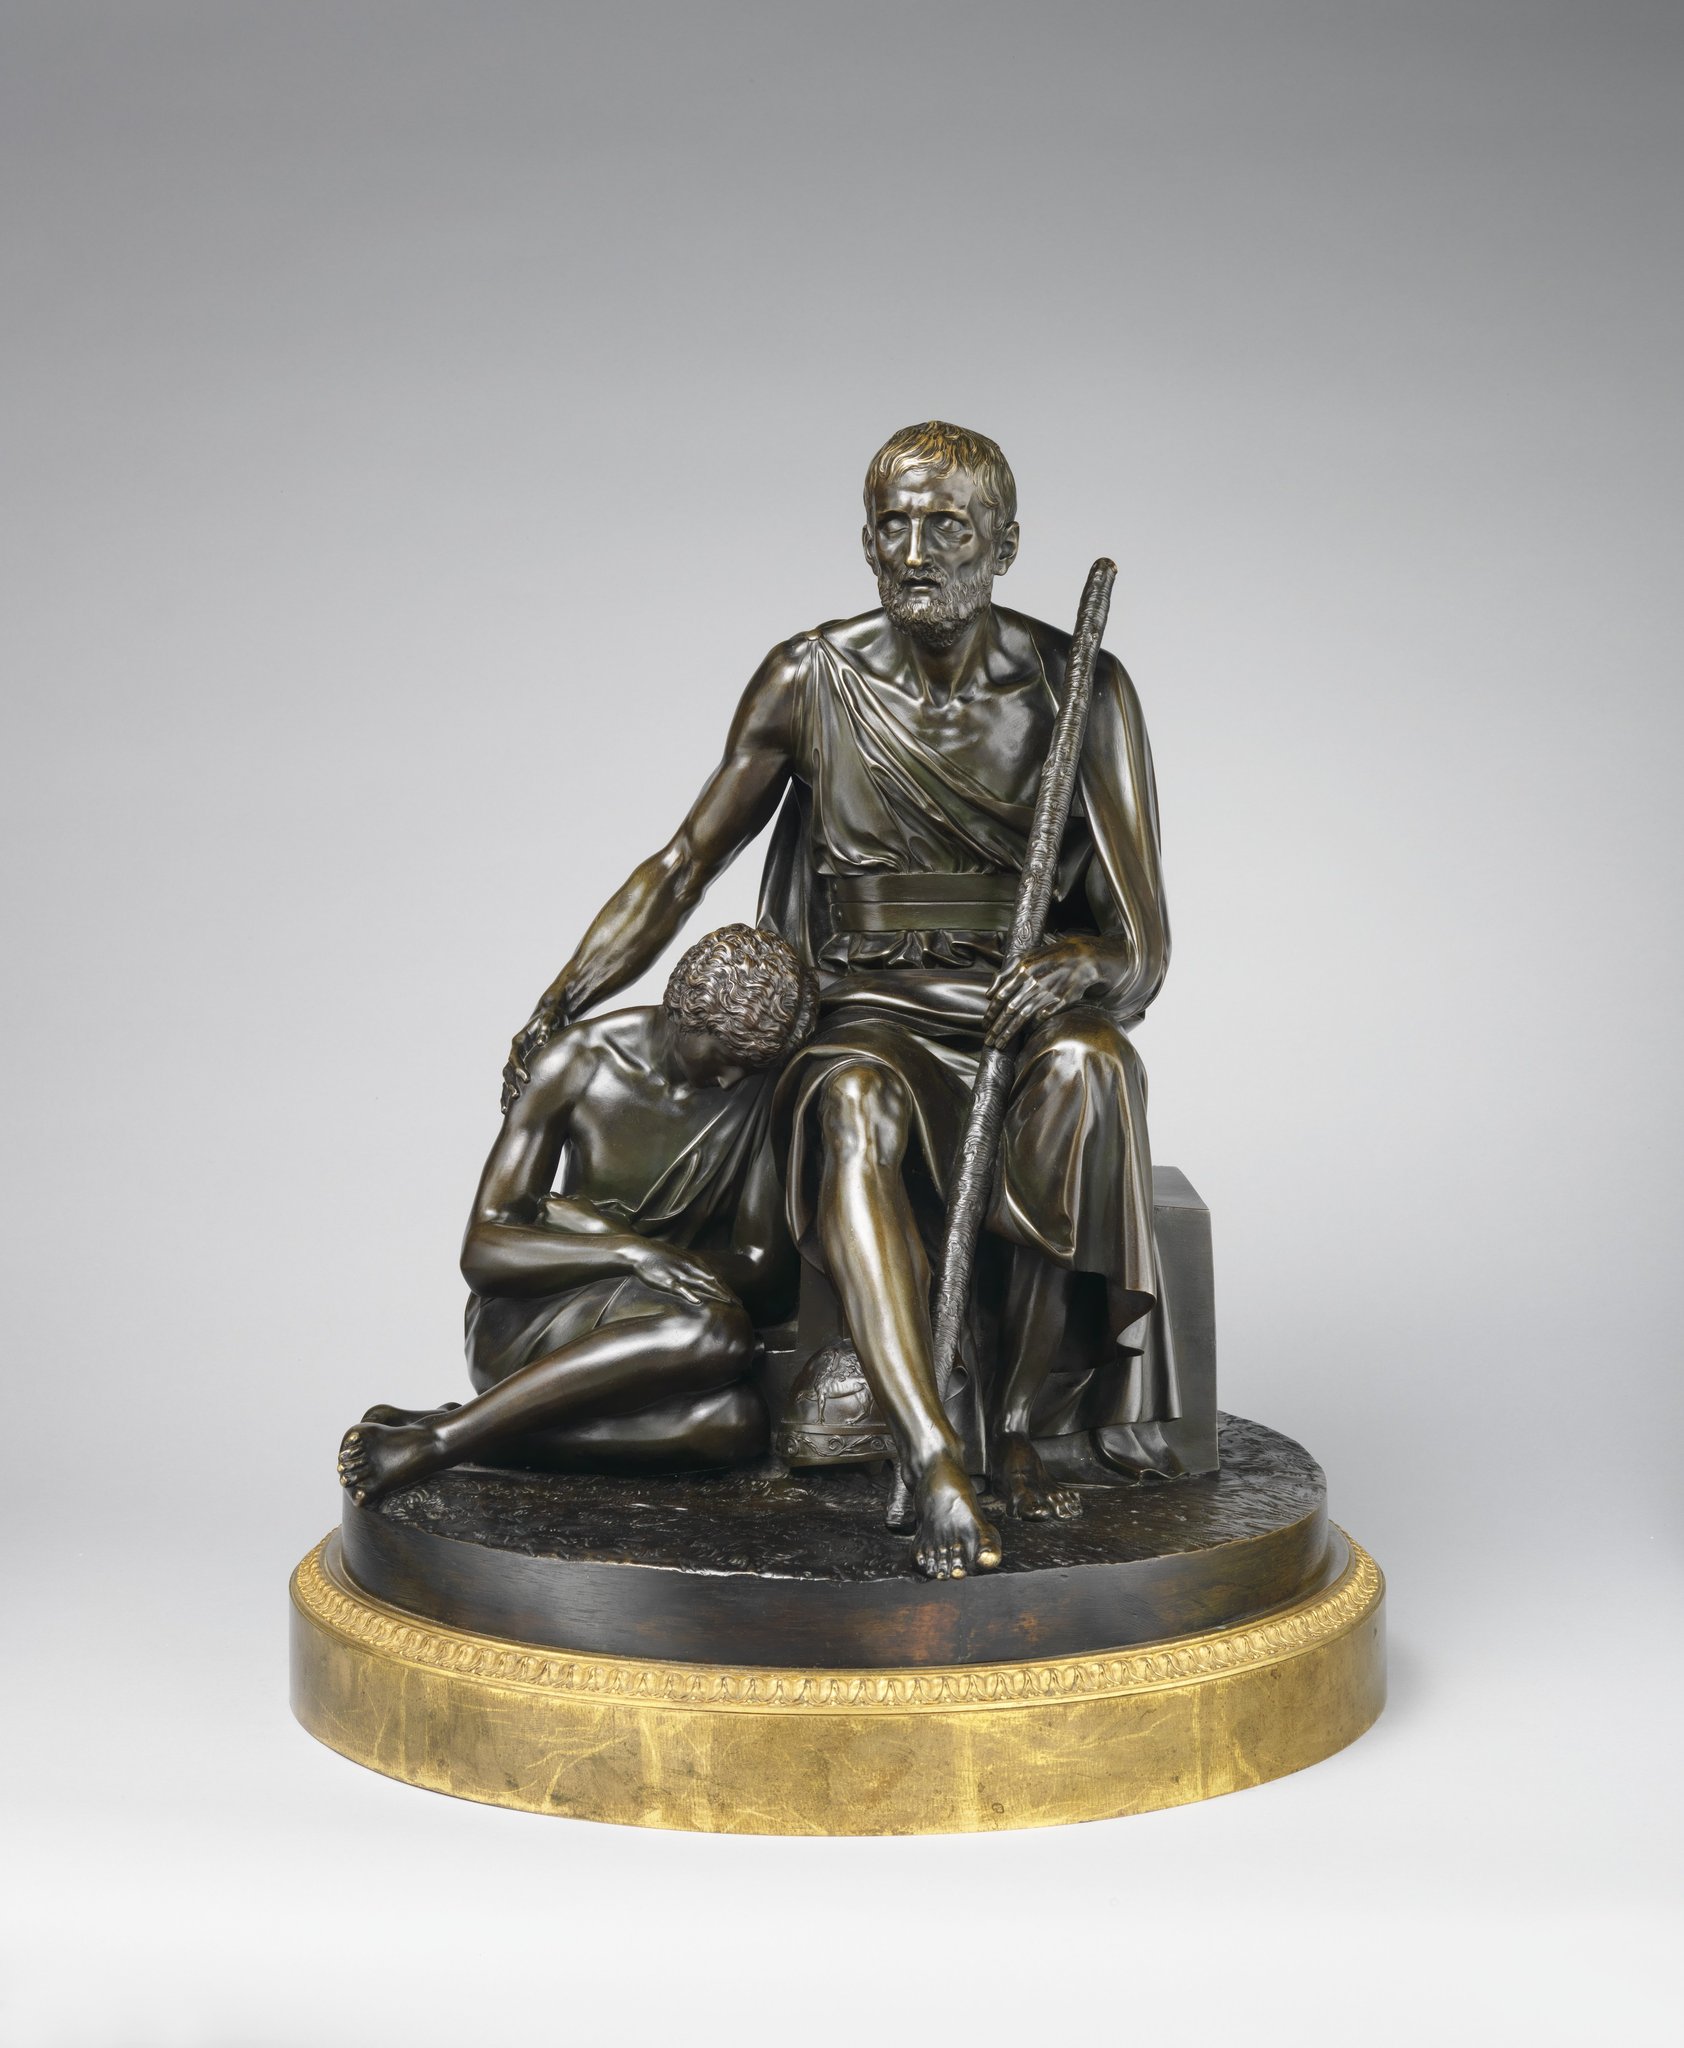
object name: statuette group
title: Belisarius and His Guide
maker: antoine denis chaudet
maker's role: artist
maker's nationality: french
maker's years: 1763-1810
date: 1794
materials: bronze, gilt bronze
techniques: painting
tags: men,generals